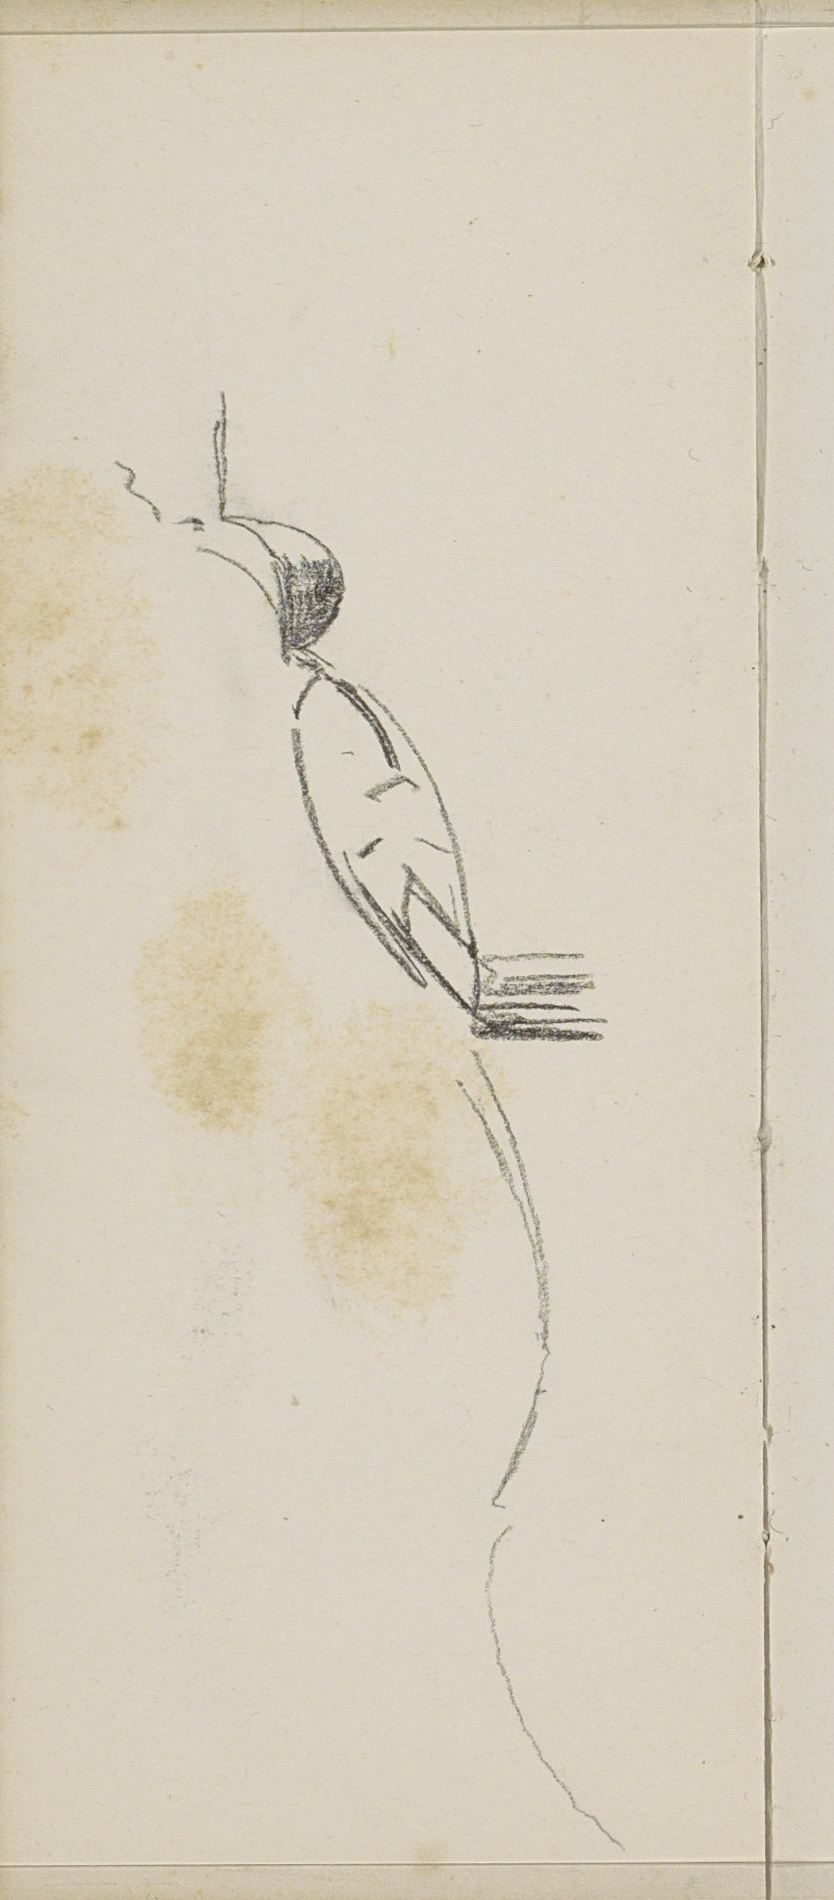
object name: sketchbook leaf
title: Ornament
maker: gerrit willem dijsselhof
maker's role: designer, draughtsman, print maker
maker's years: 1866-1924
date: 1876-1924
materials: chalk, paper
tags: ornaments ~ art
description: Blad 9 verso uit een schetsboek met 40 bladen.